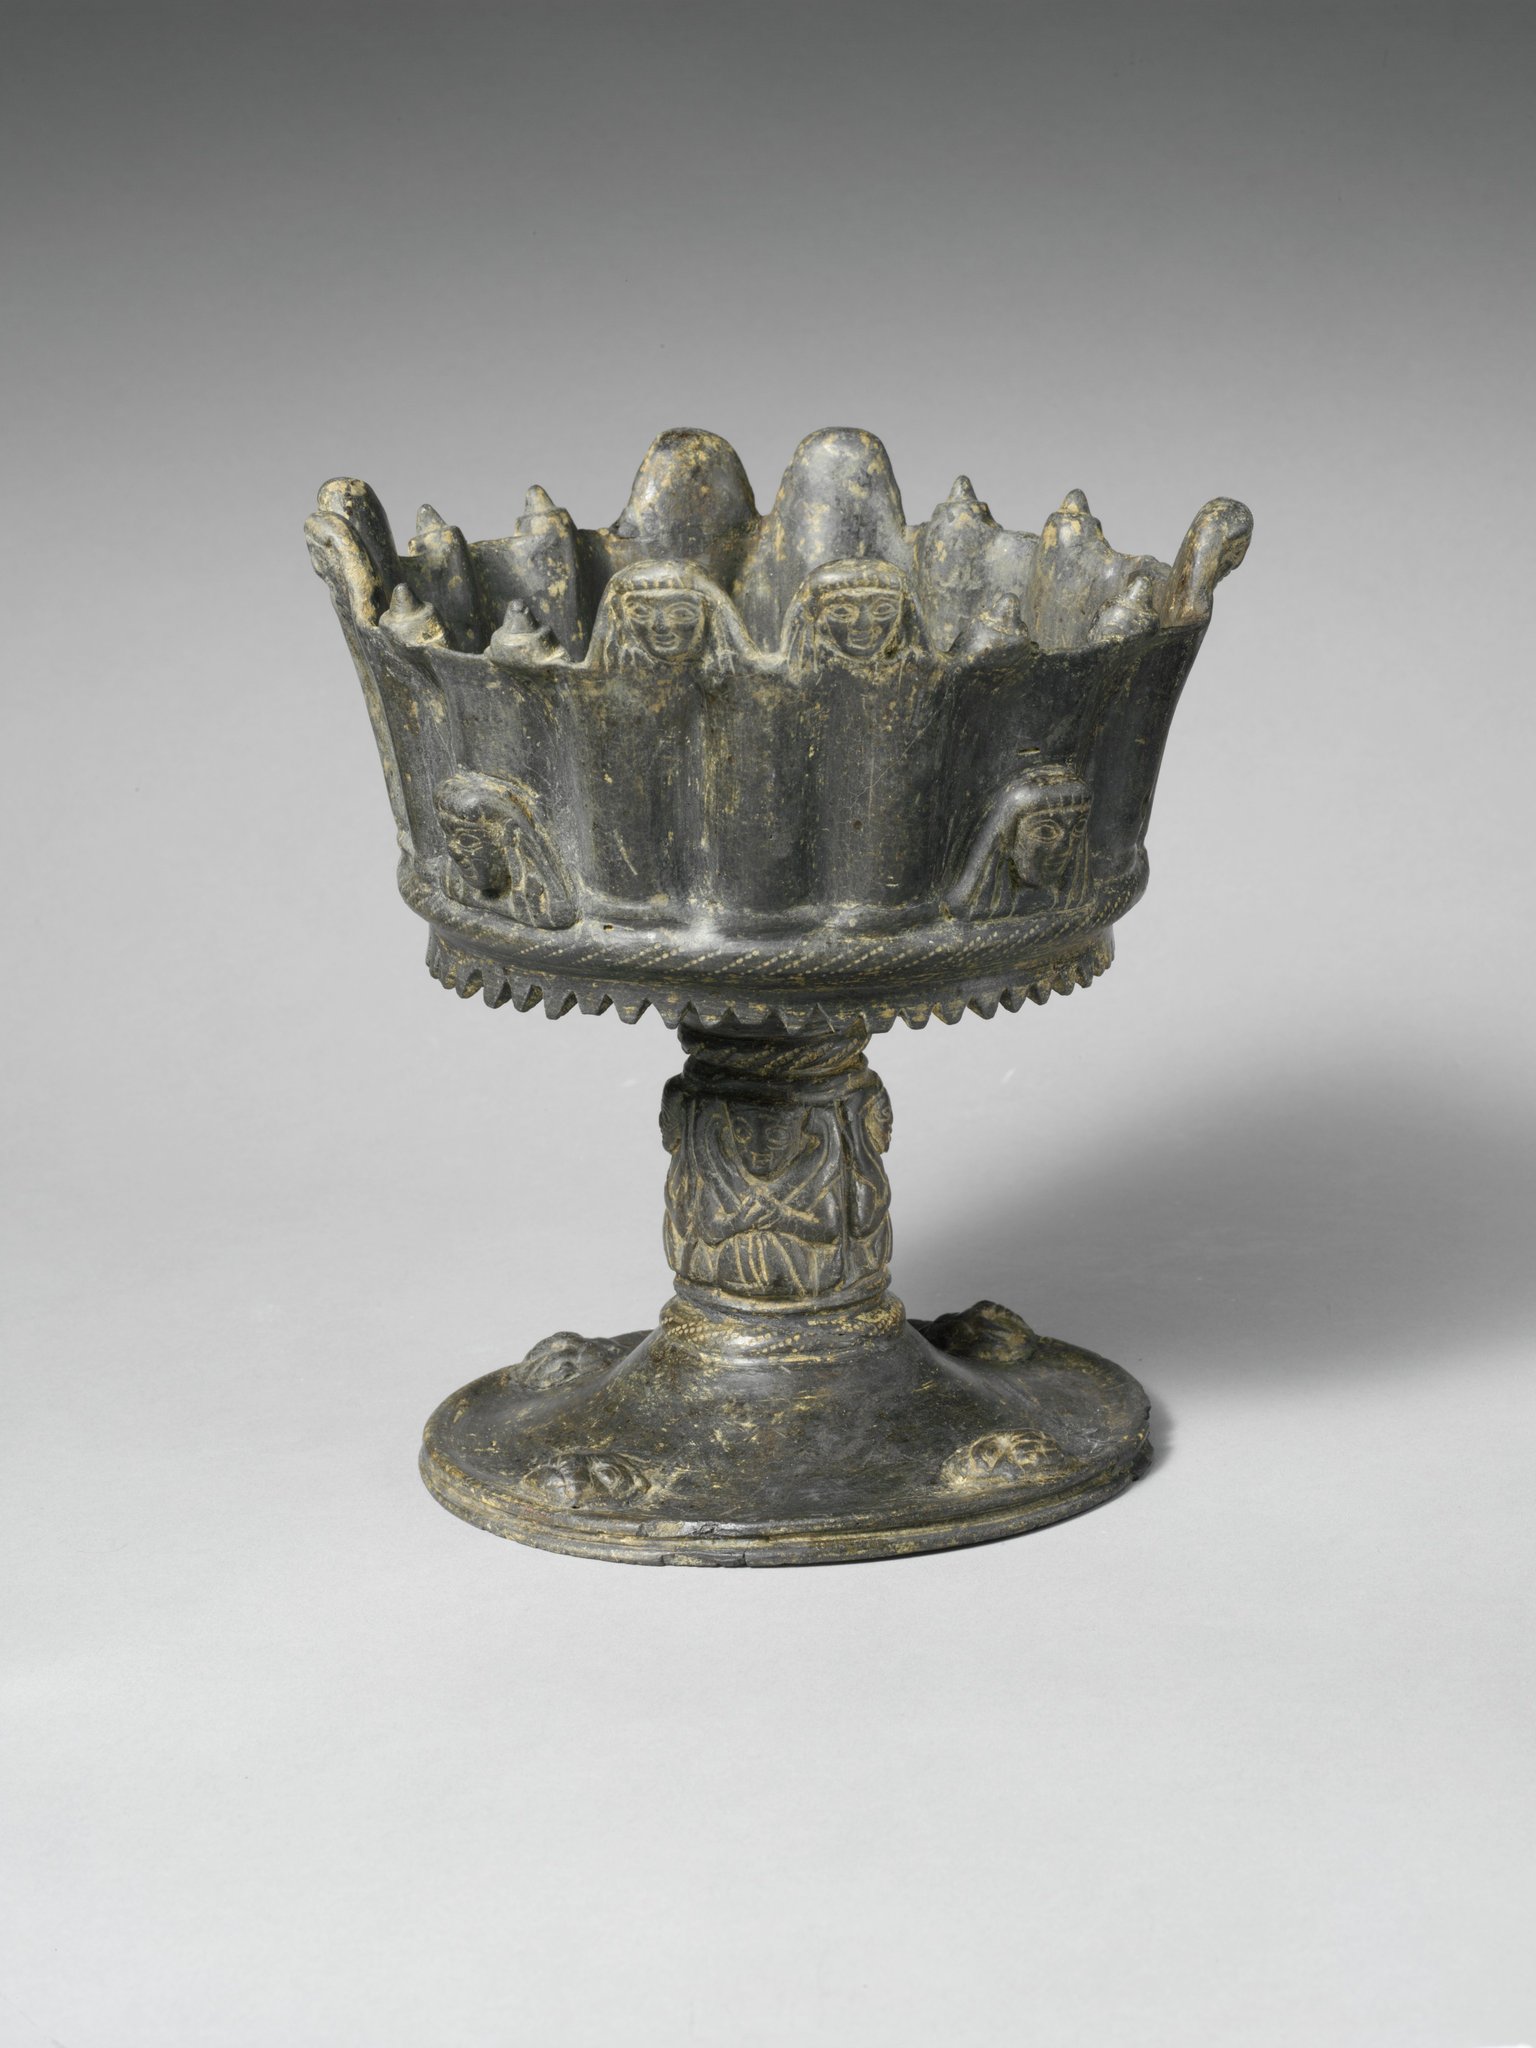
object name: cup, stemmed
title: Terracotta chalice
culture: etruscan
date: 550 BCE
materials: terracotta